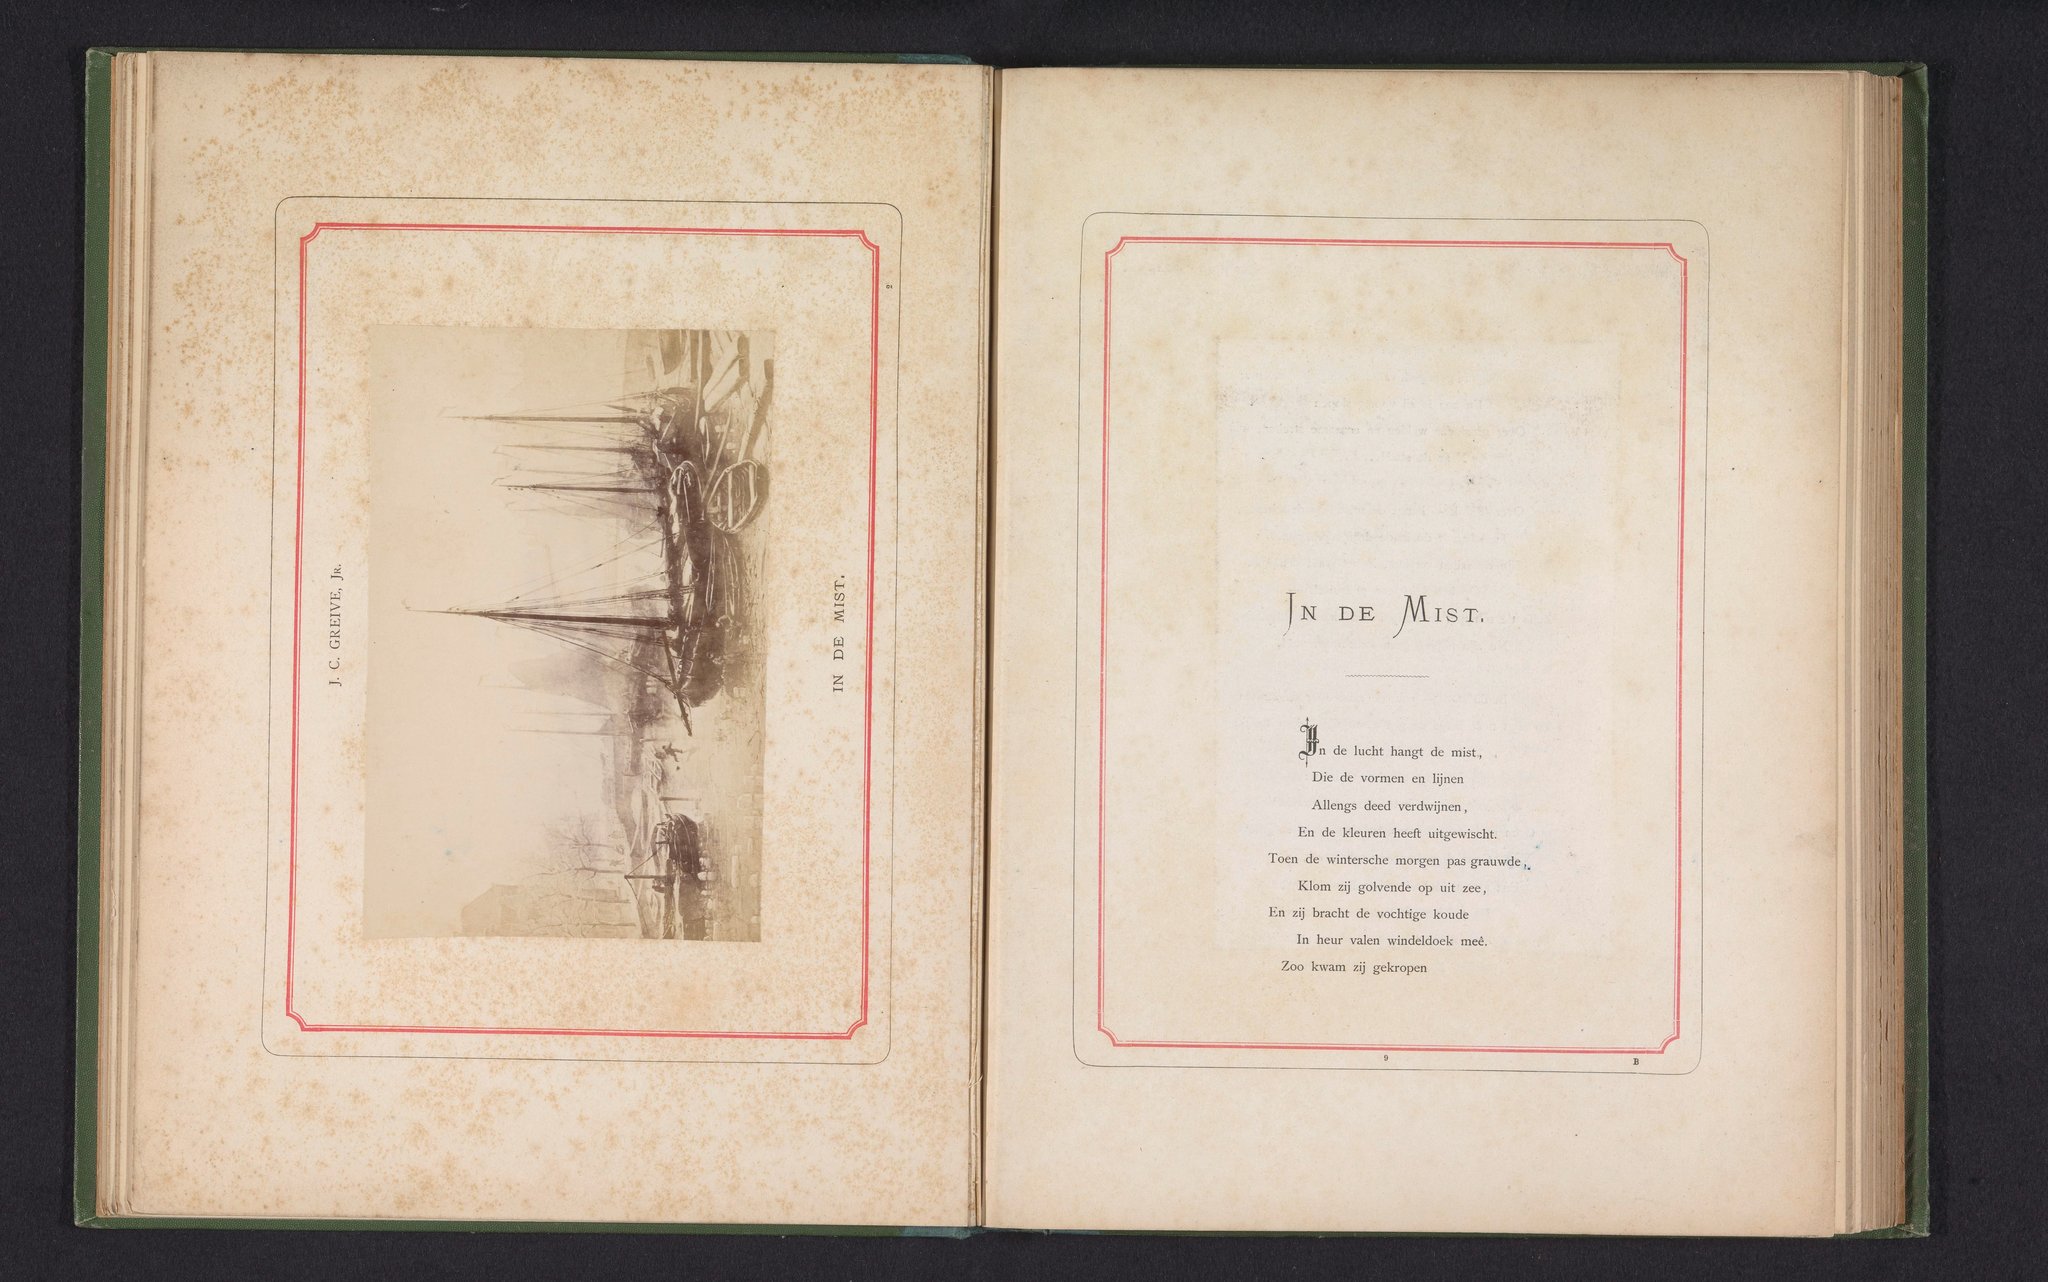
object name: photograph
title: Fotoreproductie van een schilderij, voorstellende schepen in een dichtgevroren haven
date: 1868-1878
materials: photographic support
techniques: albumen print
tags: harbour, ships (in general), ice ~ state of water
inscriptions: number: ‘2’